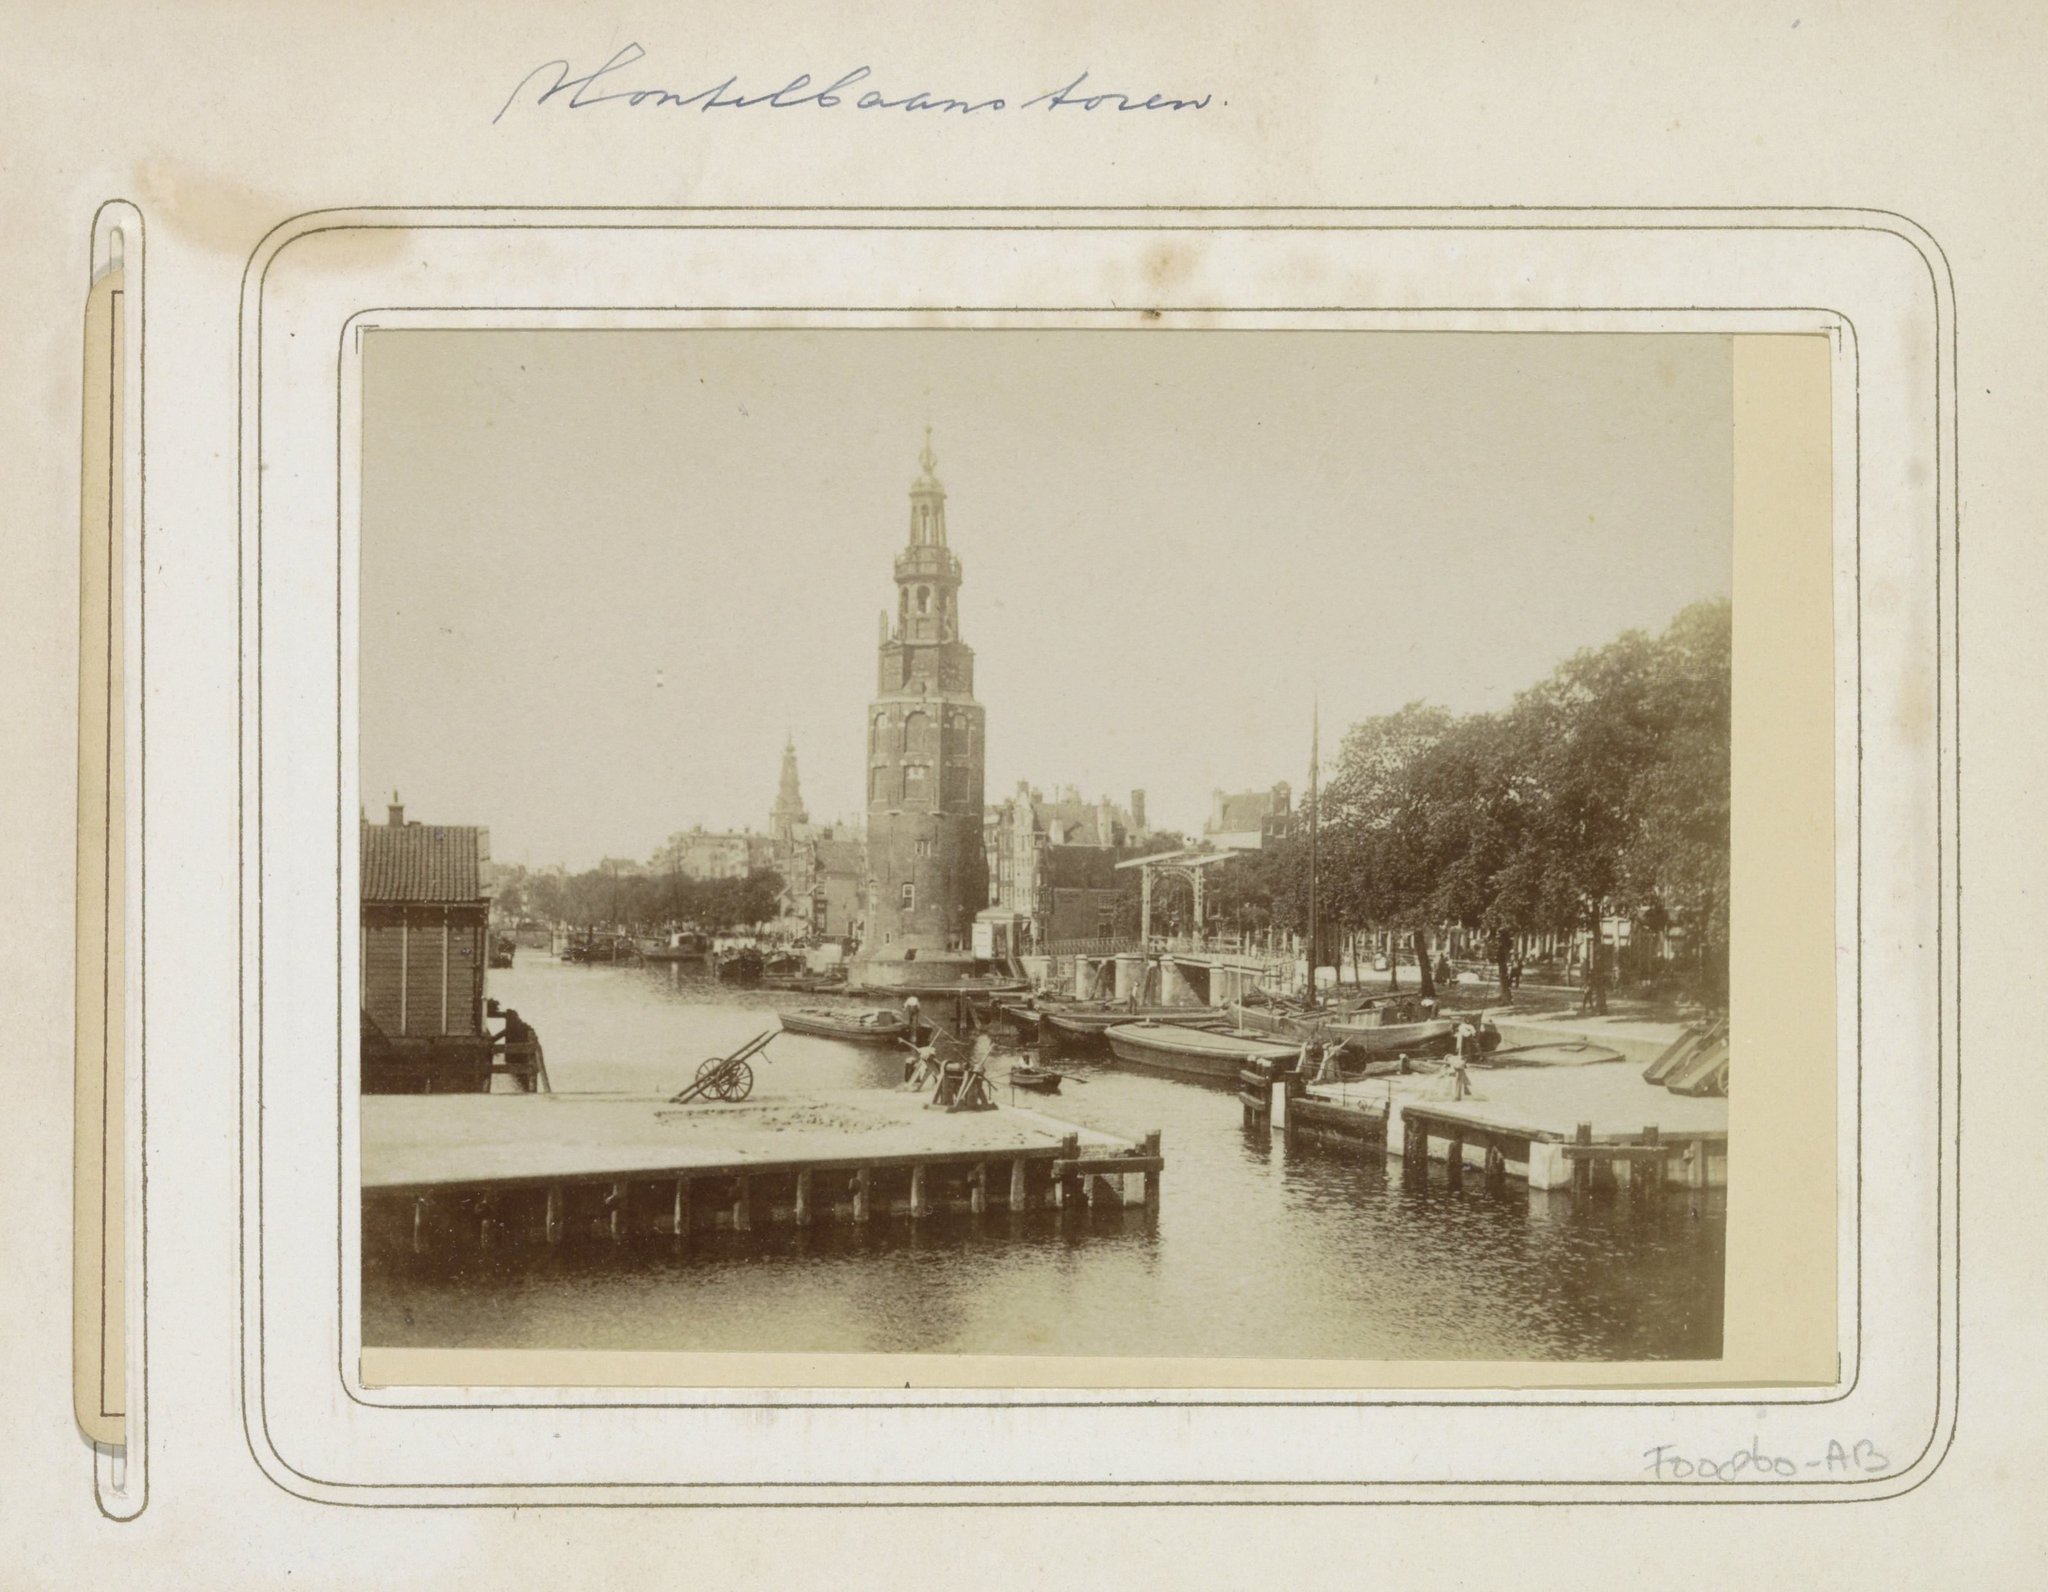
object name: photograph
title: Gezicht op de Oudeschans met de Montelbaanstoren en op de voorgrond de Kikkerbilsluis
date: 1865-1890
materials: cardboard, paper, photographic support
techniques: albumen print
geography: amsterdam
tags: sluice, weir, towers ~ fortified city, prospect of city, town panorama, silhouette of city, amsterdam